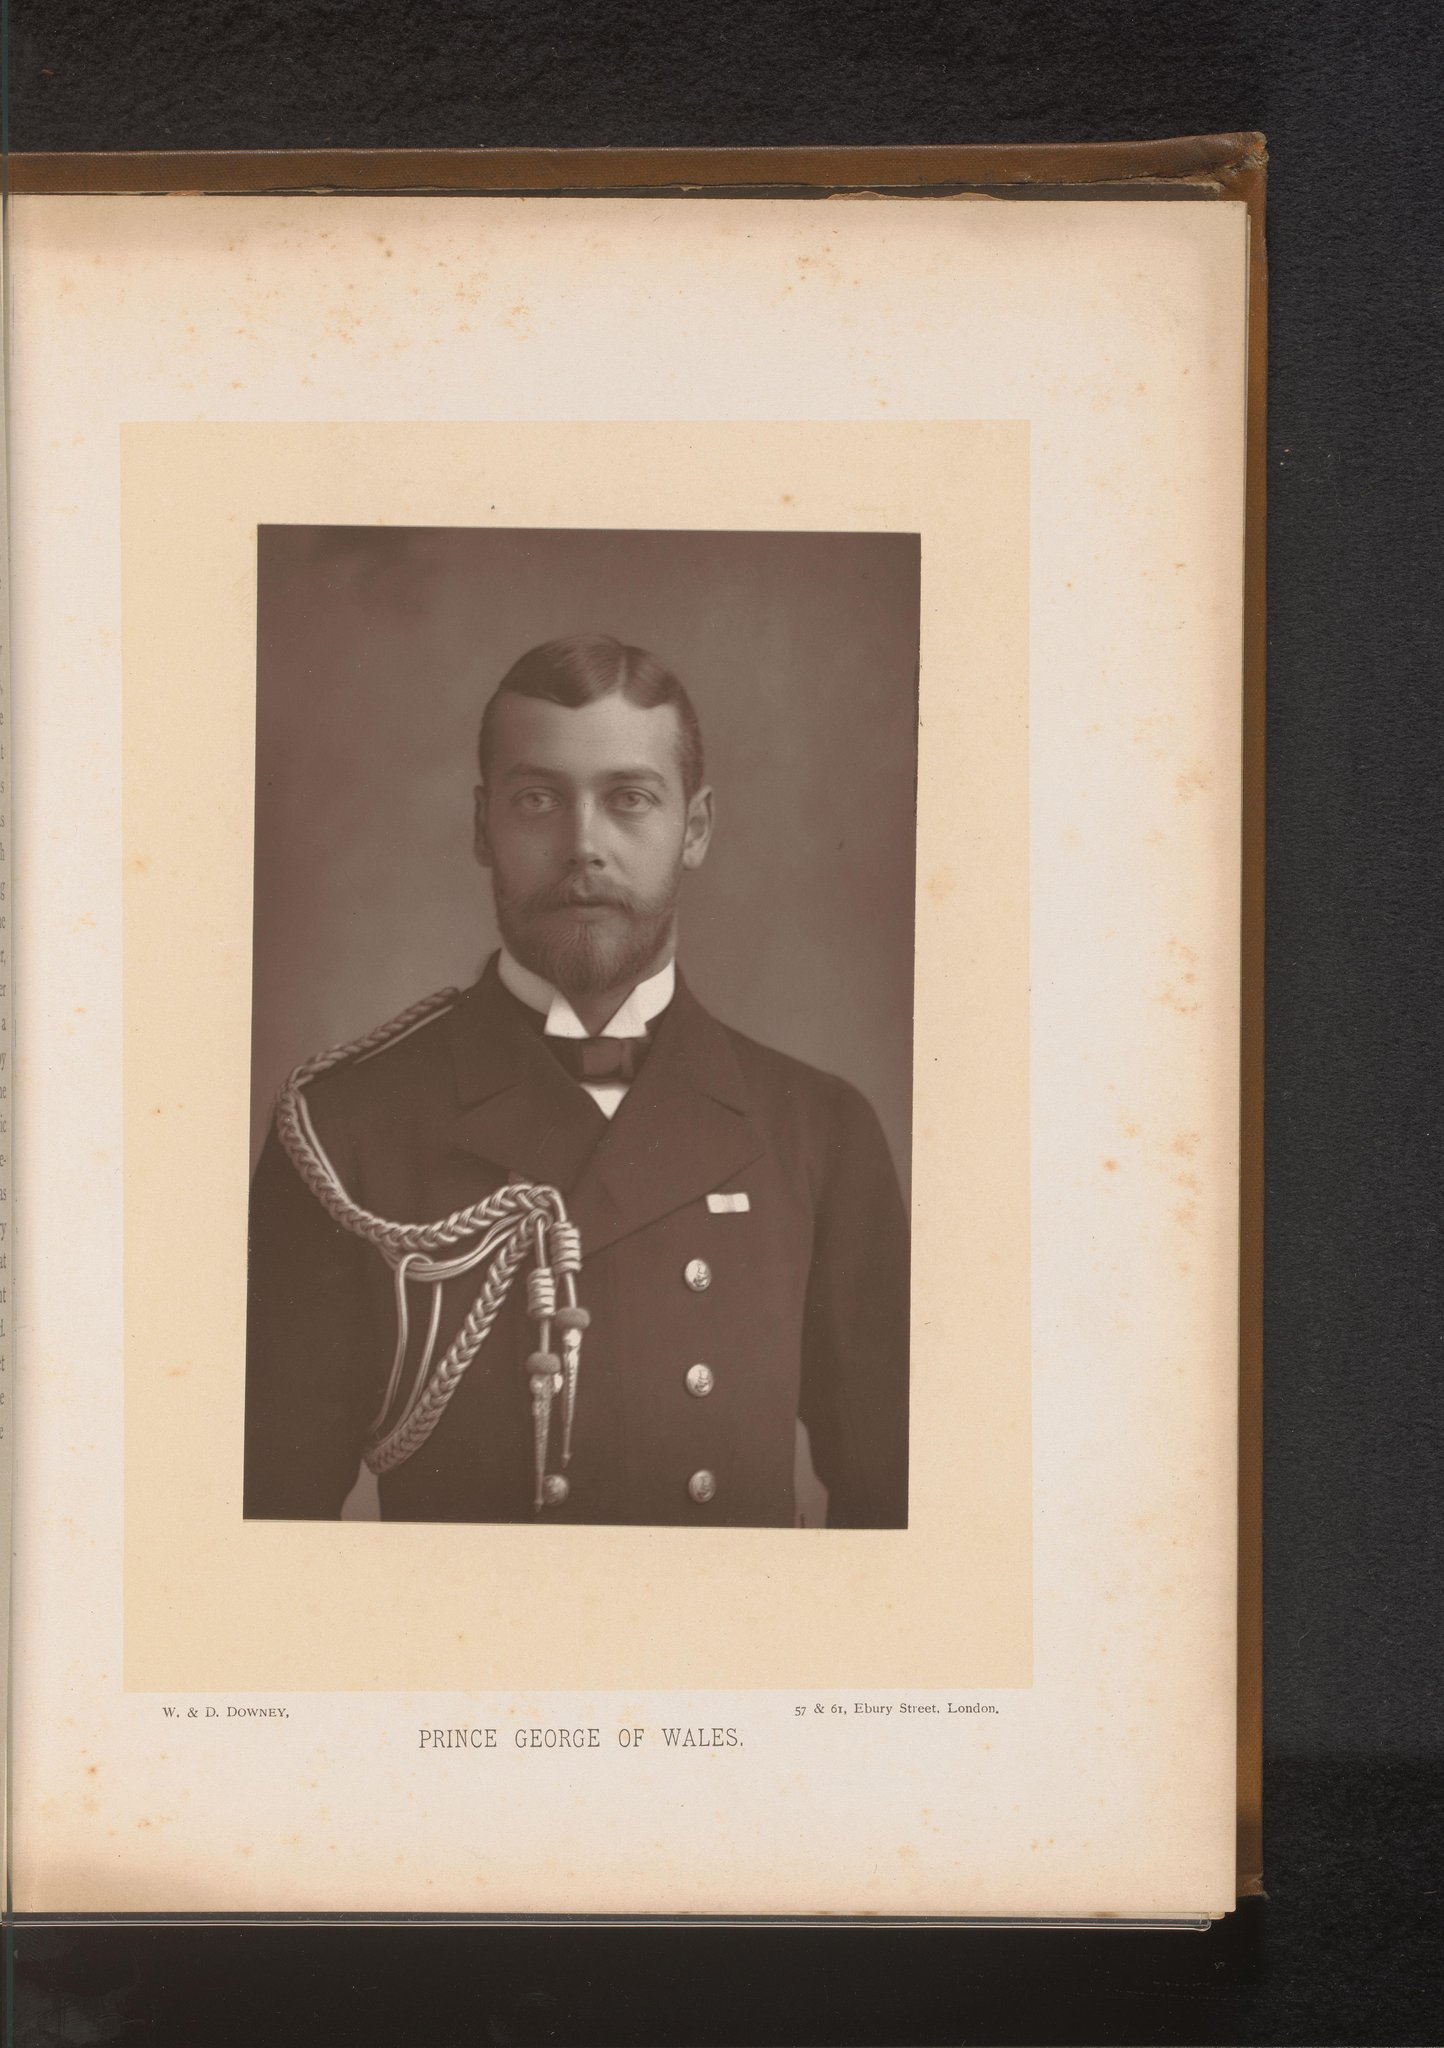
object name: photomechanical print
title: Prince George of Wales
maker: Anonymous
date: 1880-1890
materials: paper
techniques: woodburytype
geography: london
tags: ruler, sovereign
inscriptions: inscription: ‘57 & 61, Elbury Street, London.’